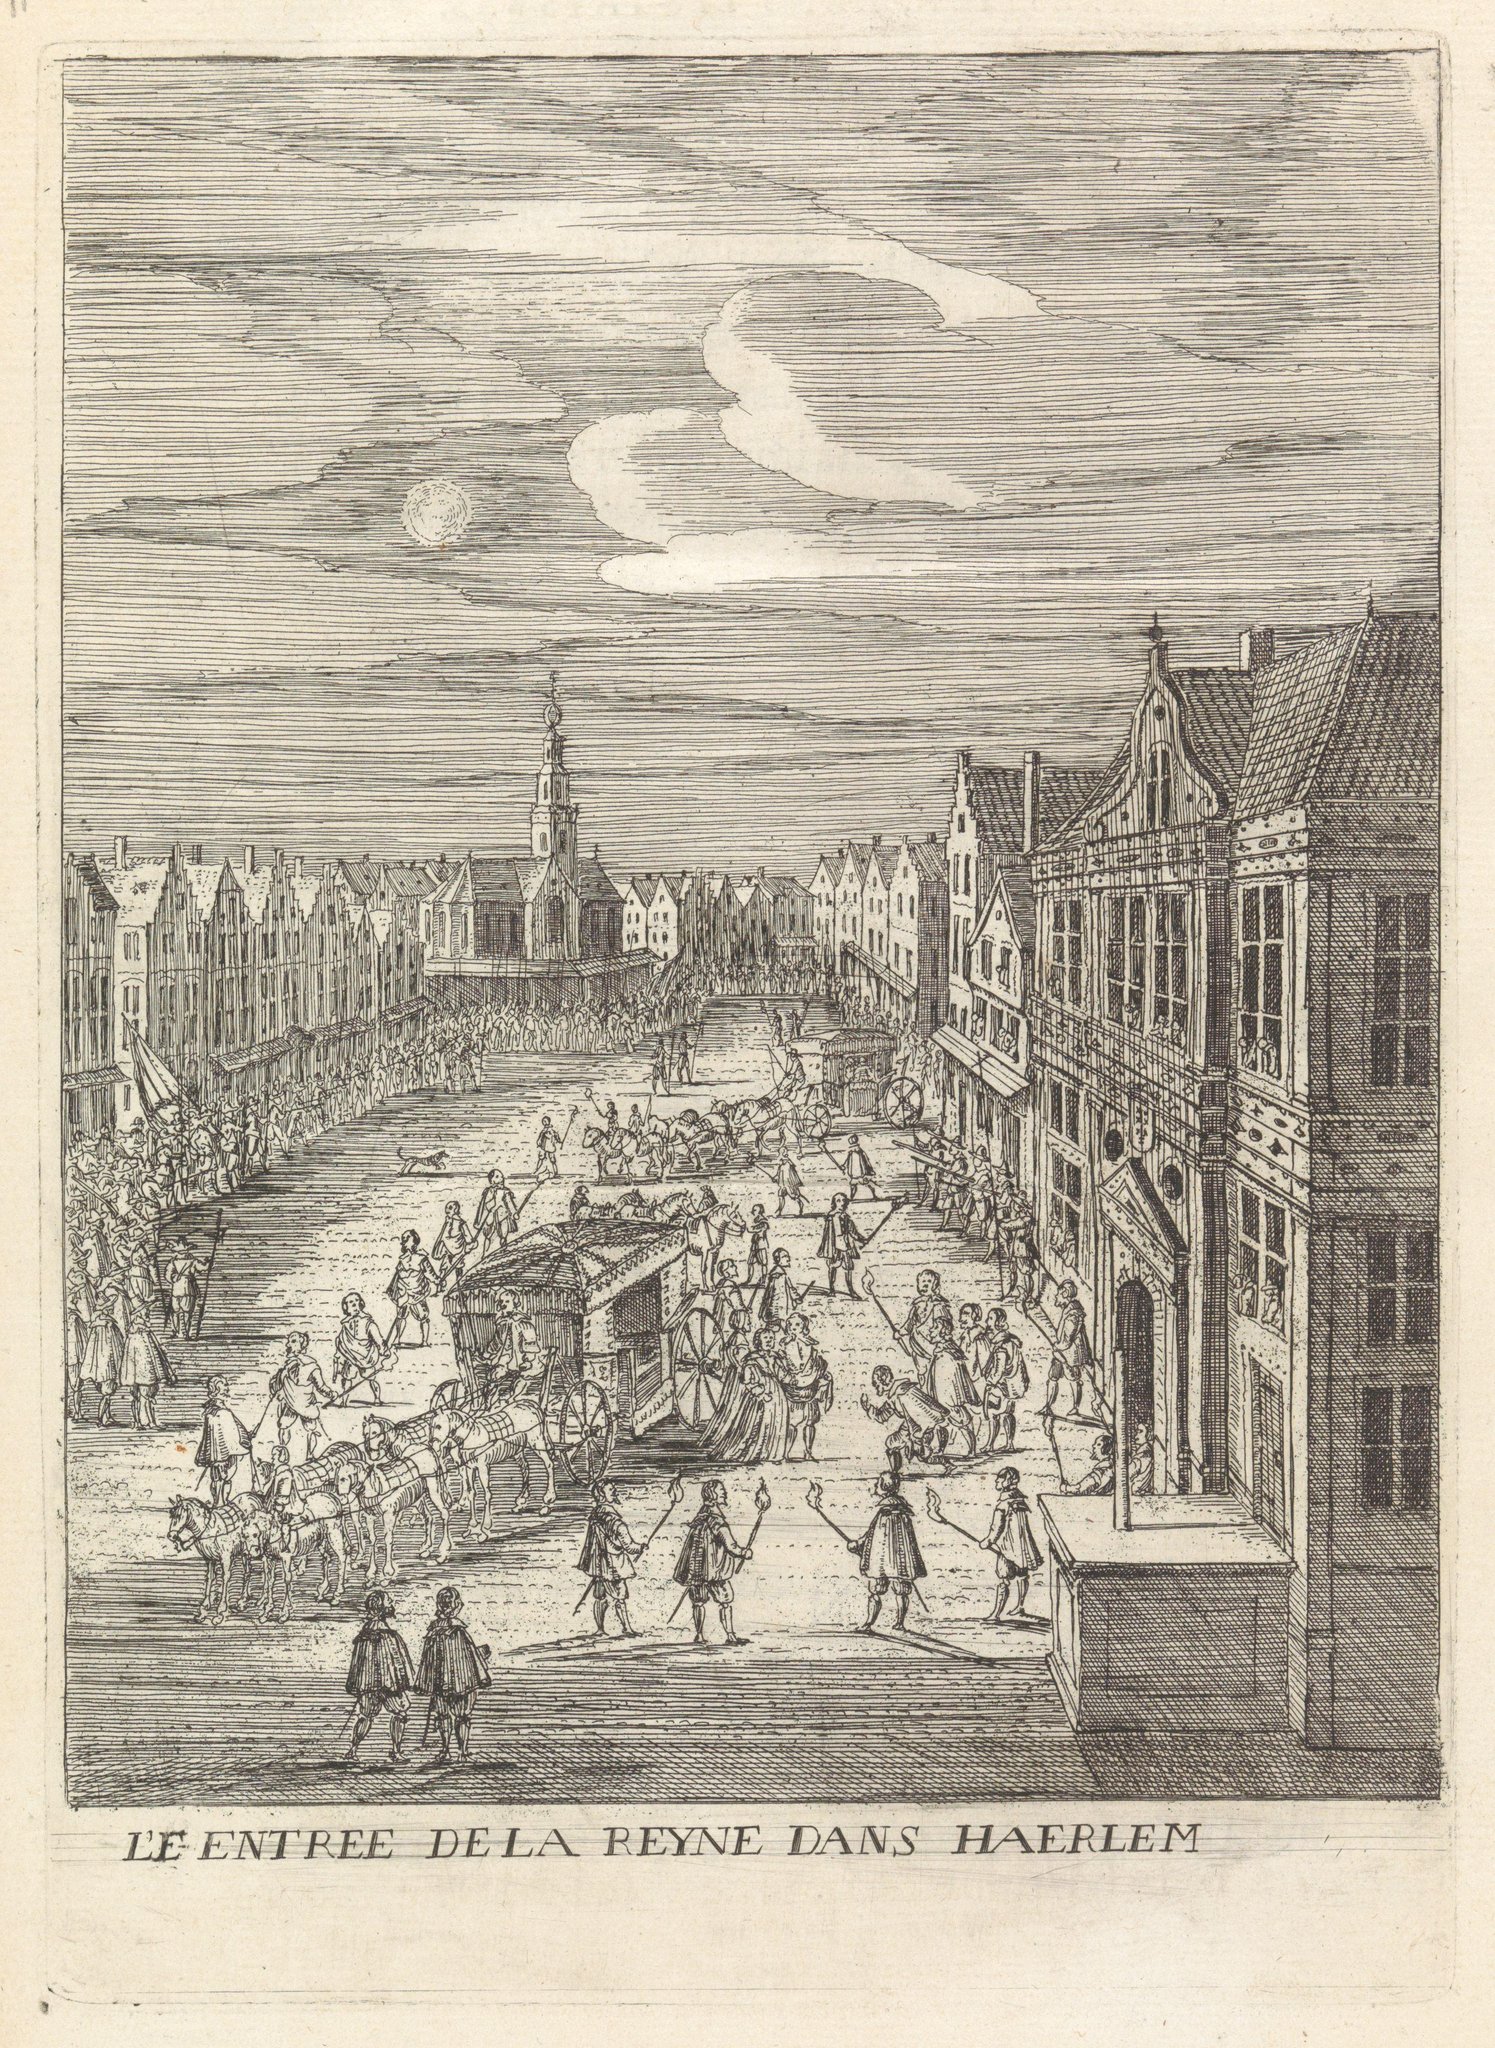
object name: book illustration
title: Aankomst van Maria de' Medici in Haarlem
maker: Anonymous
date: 1639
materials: paper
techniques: etching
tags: cologne, print maker, maria de' medici, triumphal entry and public reception, pageant, 'entrée solennelle', 'joyeuse entrée', haarlem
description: Maria de' Medici arriveert op de Markt in Haarlem. Ze is uit haar rijtuig gestapt en een man maakt een buiging voor haar. Daaromheen verschillende mannen met fakkels. De prent maakt deel uit van een boek over het bezoek van Maria de' Medici aan de Nederlanden.